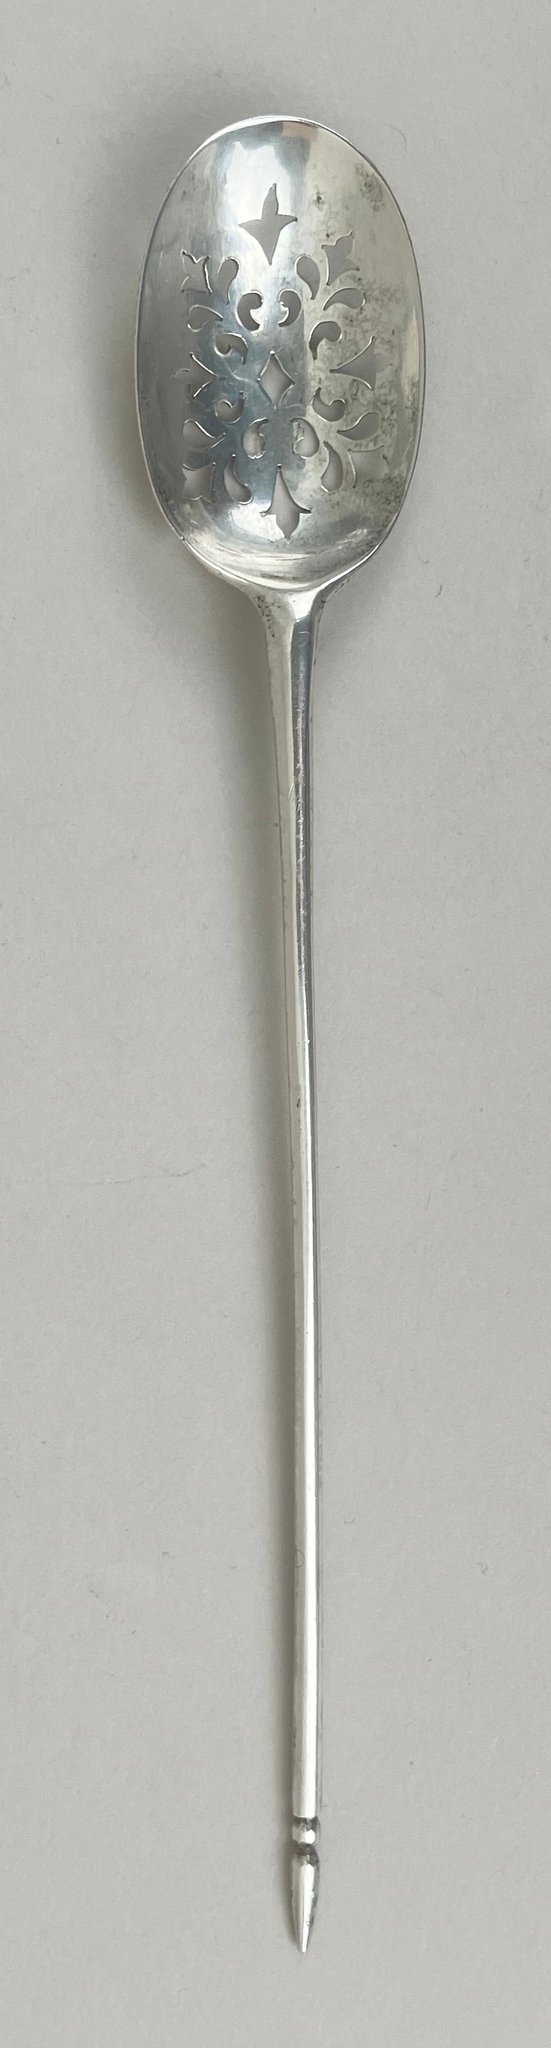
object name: strainer spoon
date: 1701-1800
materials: silver